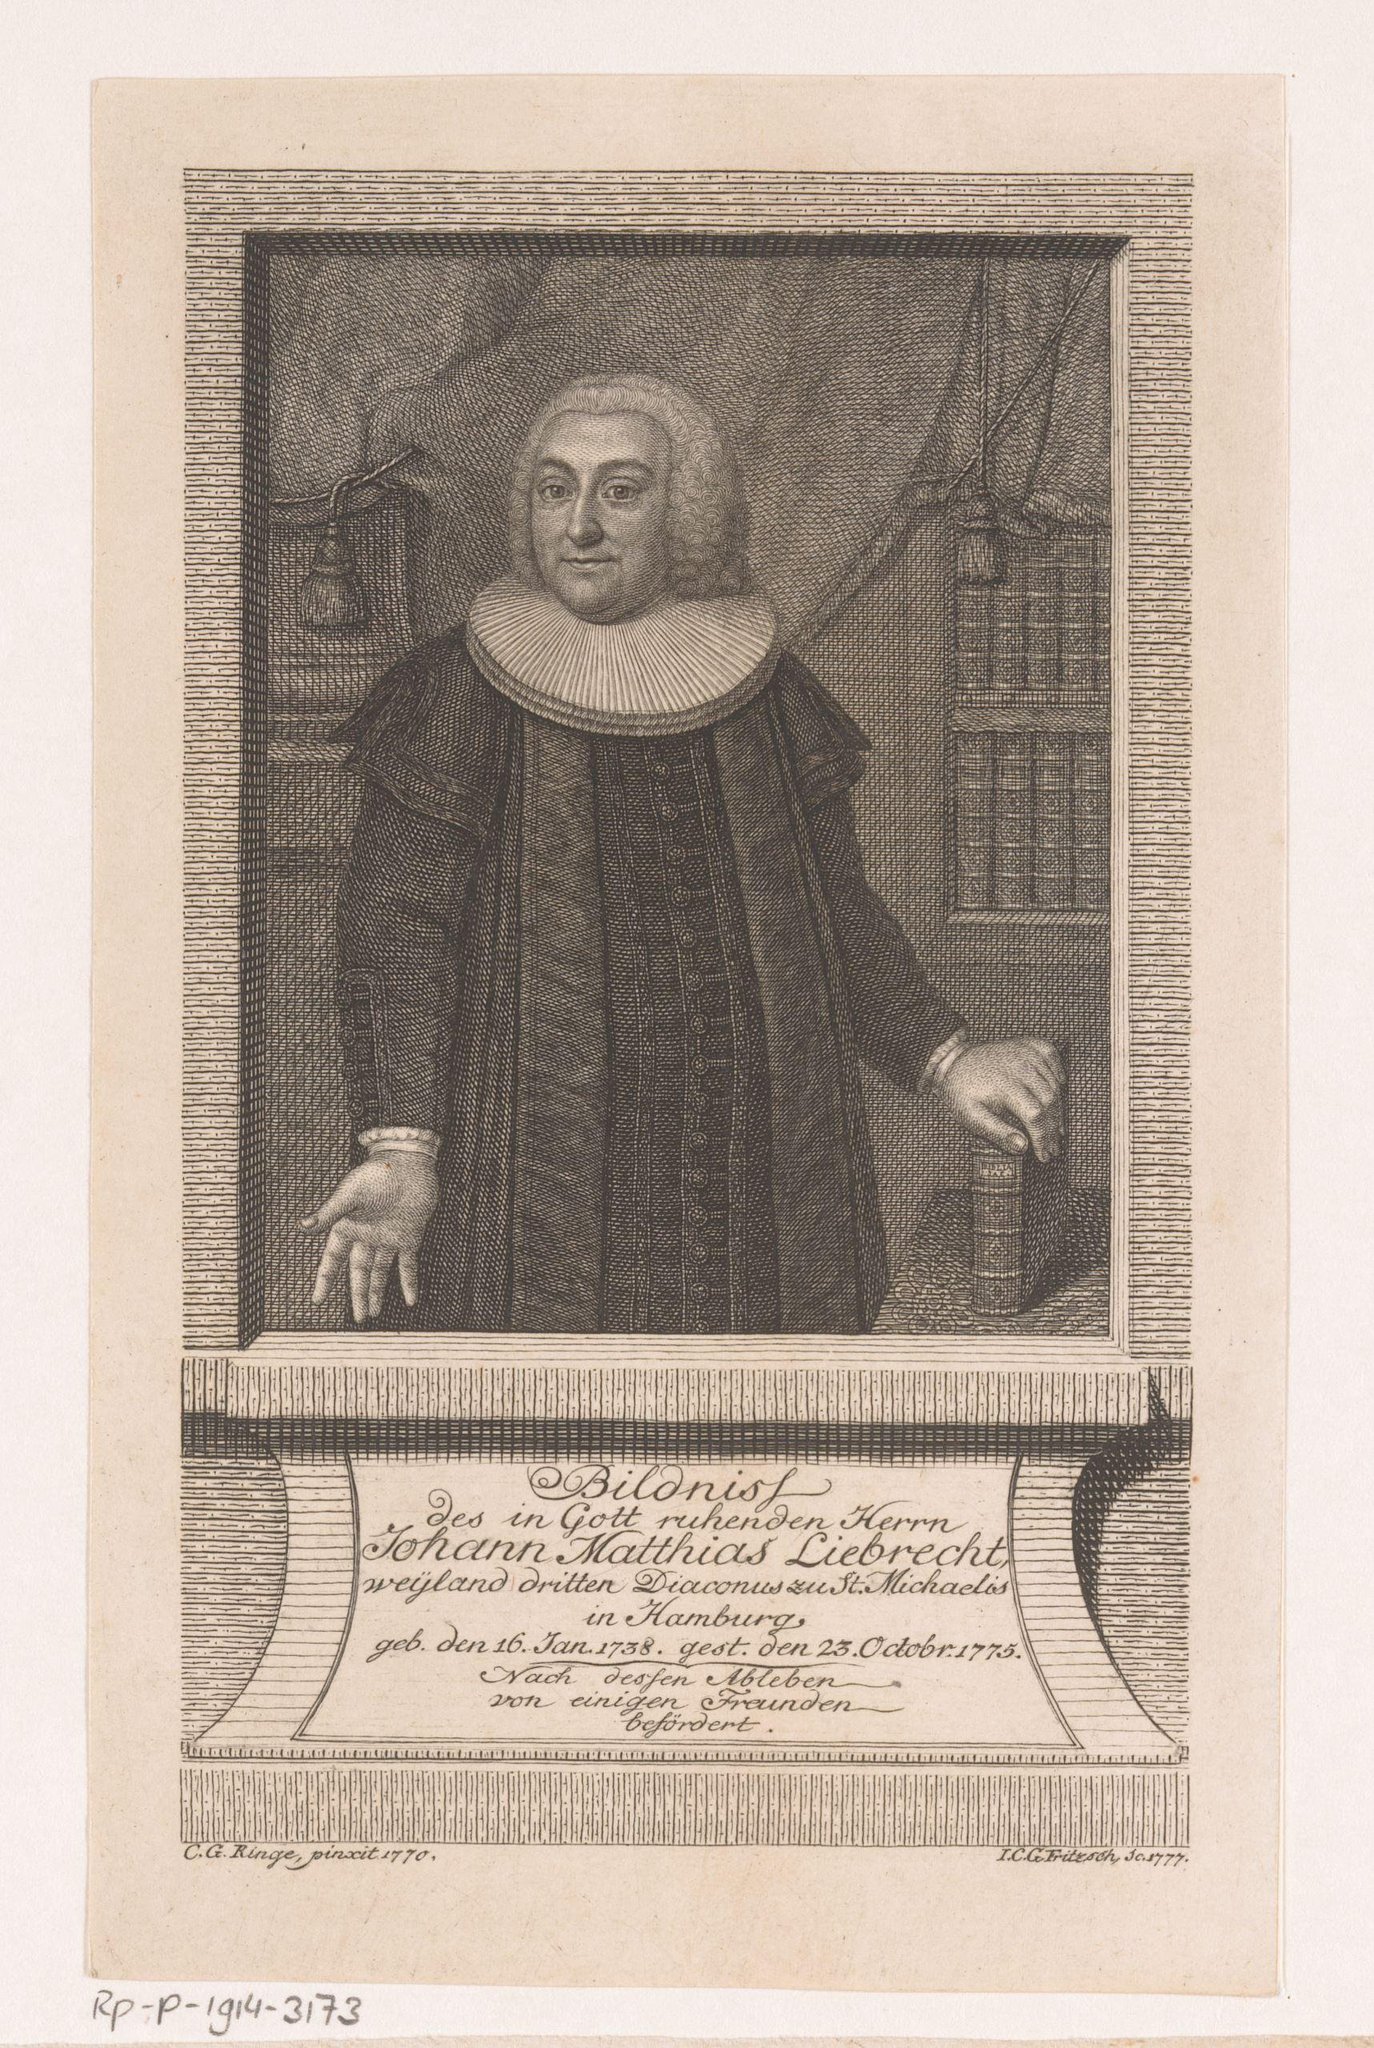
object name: print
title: Portret van Johann Matthias Liebrecht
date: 1770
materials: paper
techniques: engraving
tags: bookshelves, historical persons, book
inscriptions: collector's mark: Lugt 2228